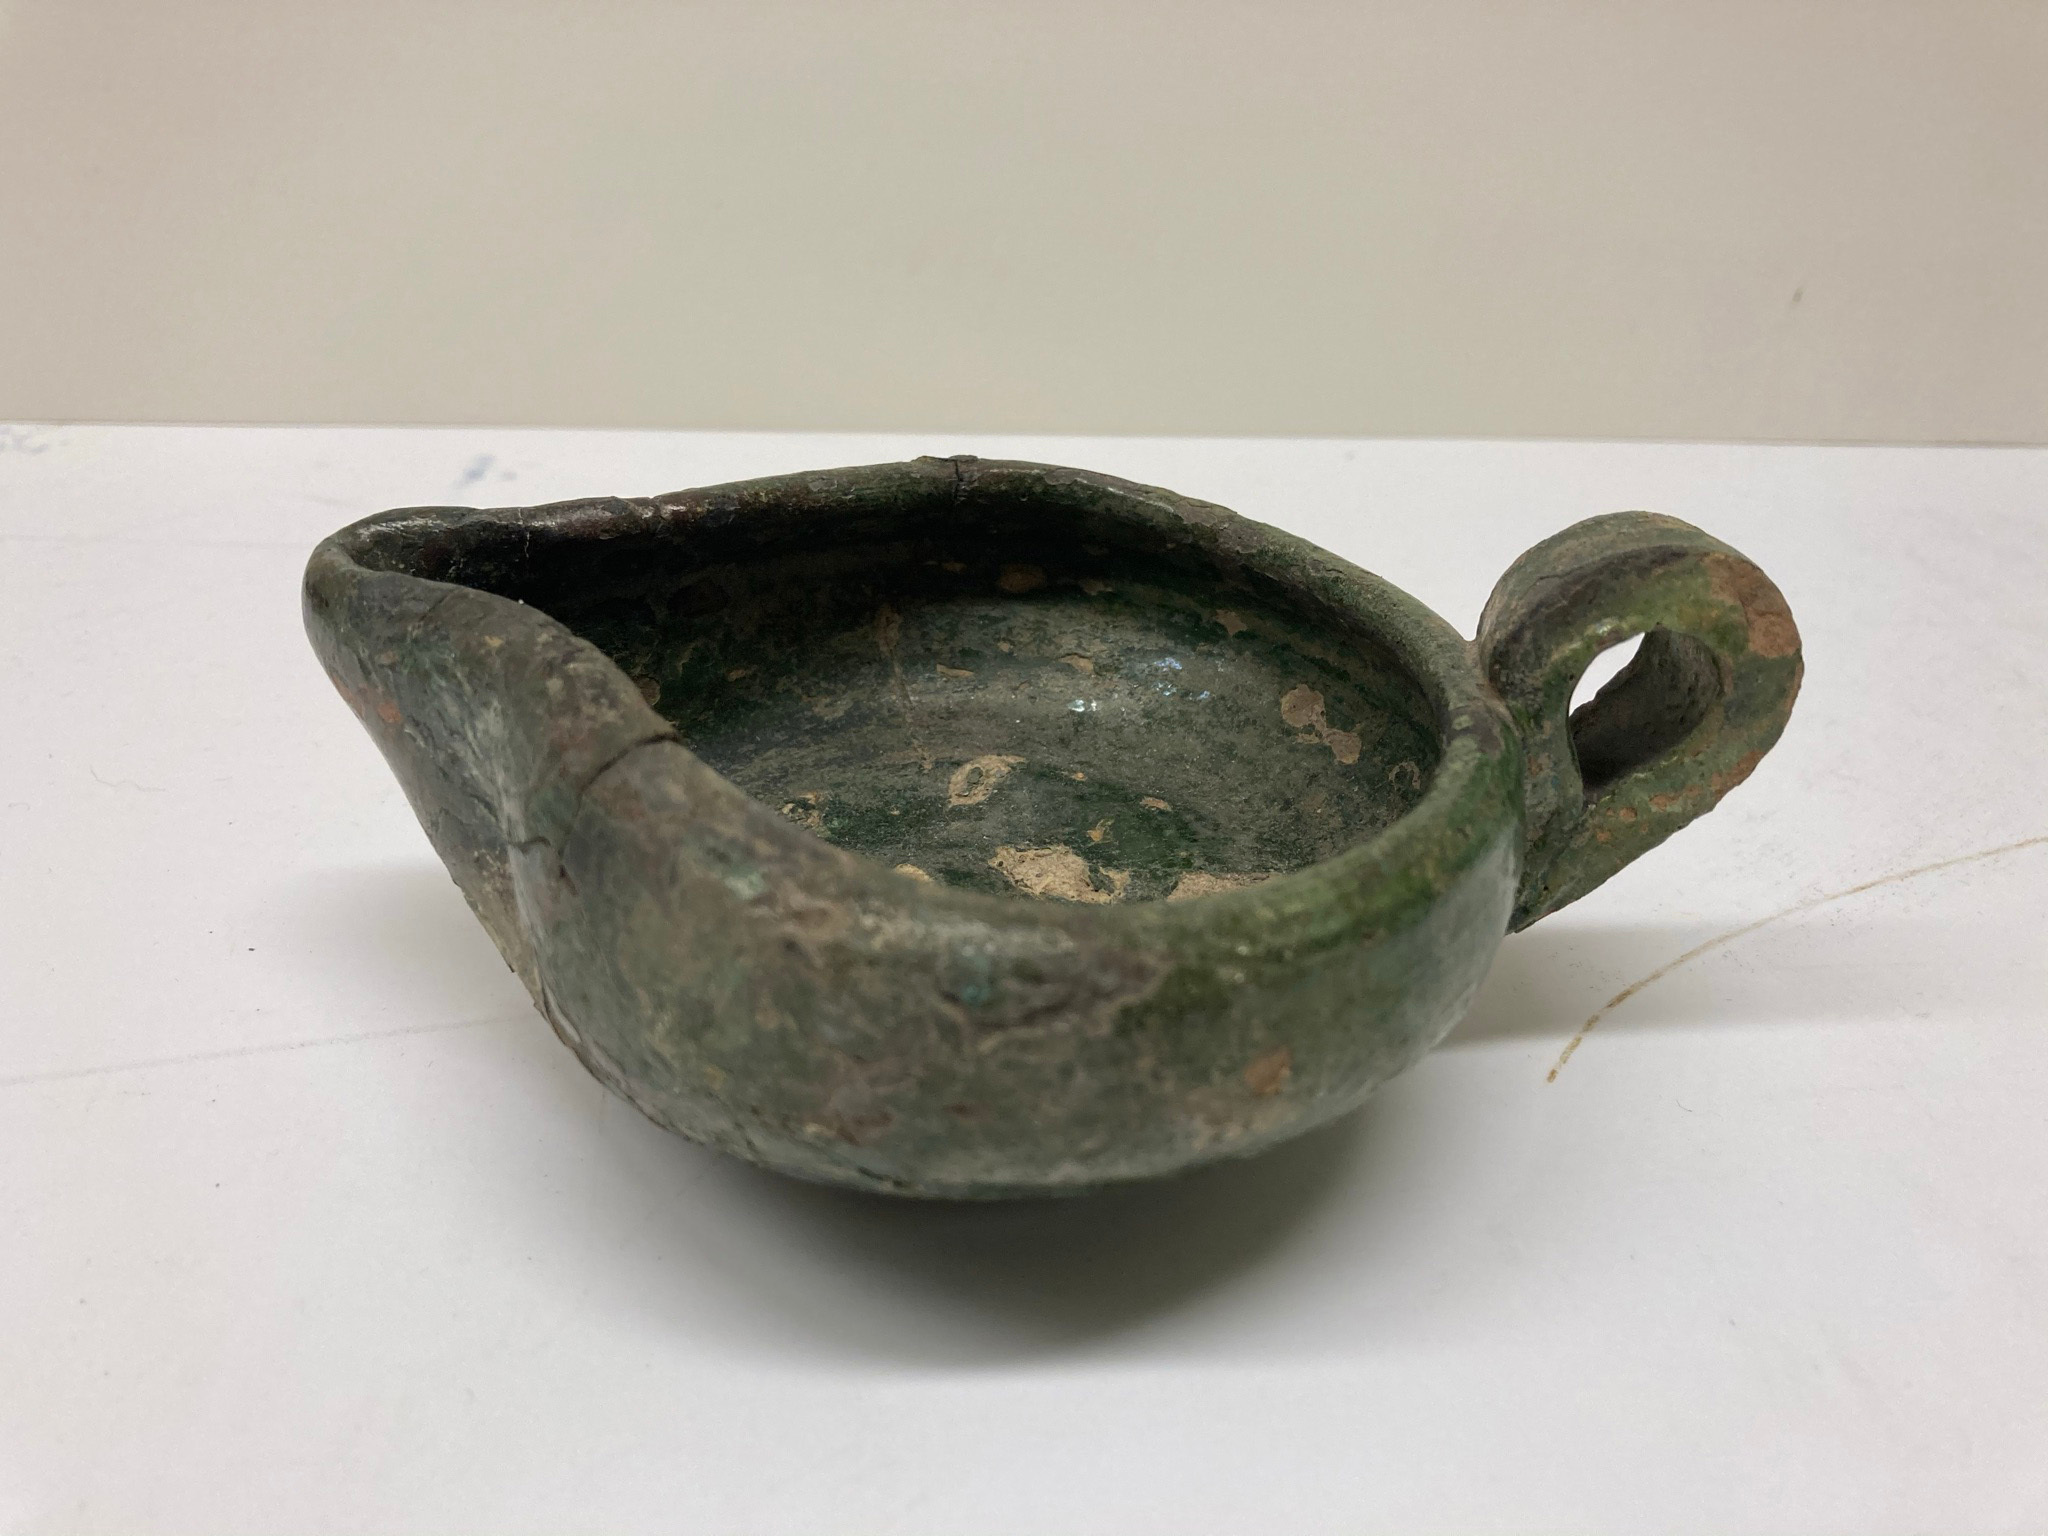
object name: lamp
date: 801-1000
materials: earthenware, glaze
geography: iran